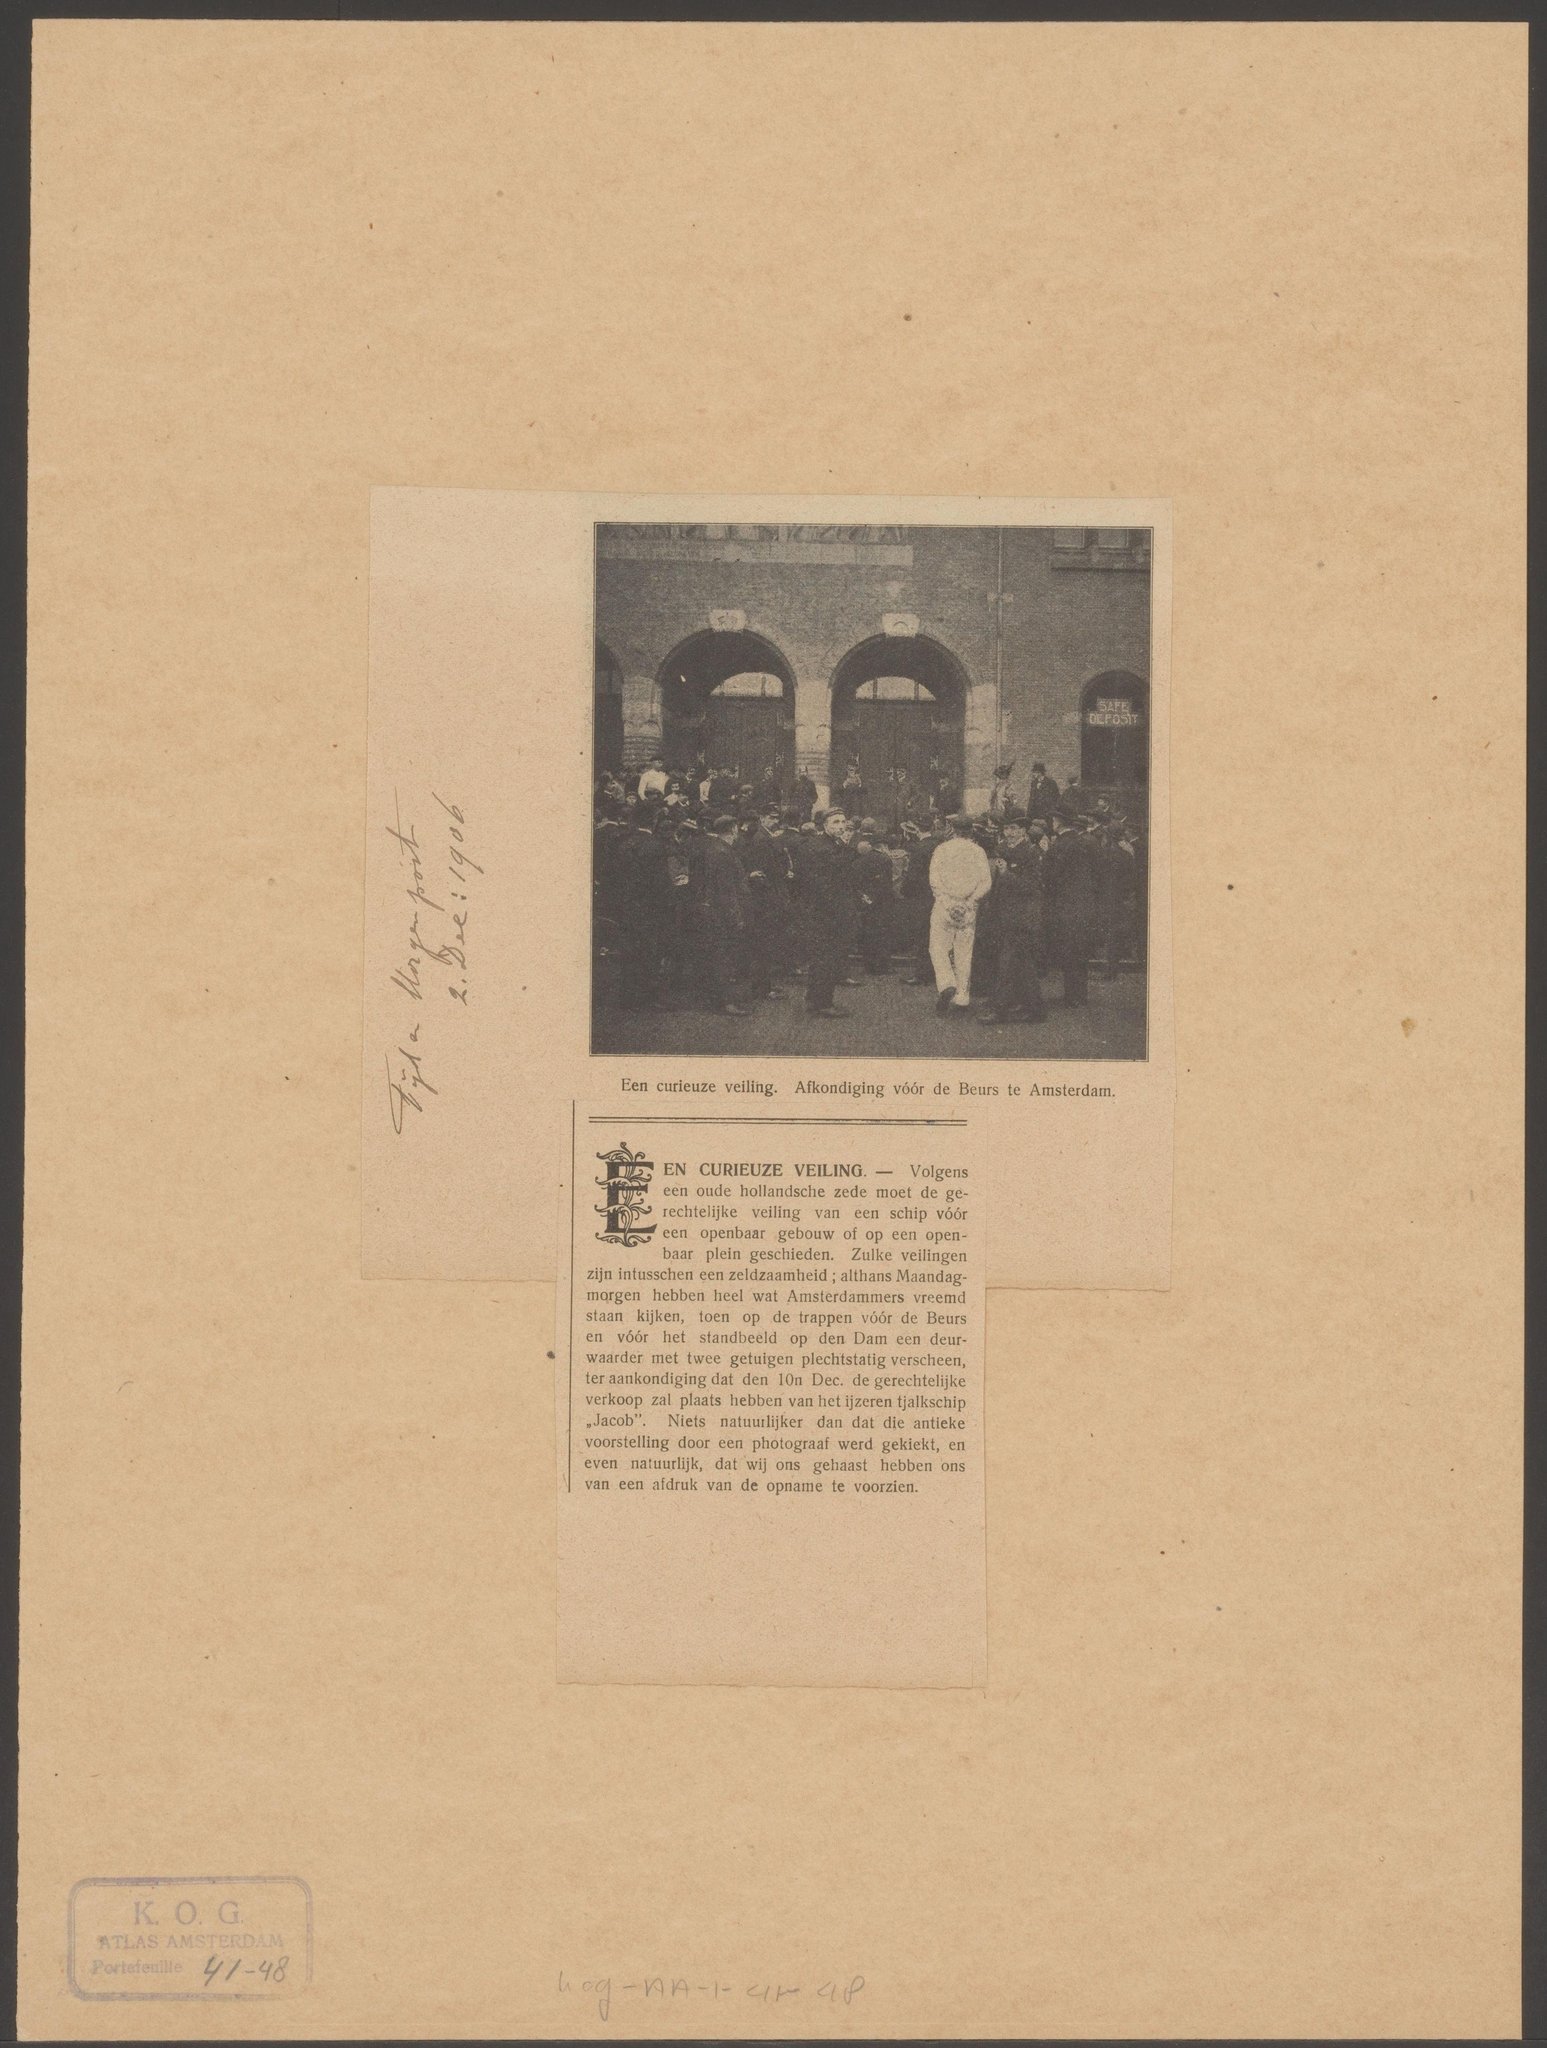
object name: photomechanical print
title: Aankondiging van de veiling van een tjalk bij de Beur van Berlage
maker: Anonymous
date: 1906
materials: paper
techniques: letterpress printing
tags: stock exchange, stock-market, amsterdam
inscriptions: collector's mark: Lugt 1461b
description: Onderwerpsrubriek binnen de Atlas Amsterdam: B. Beurs op het Damrak.